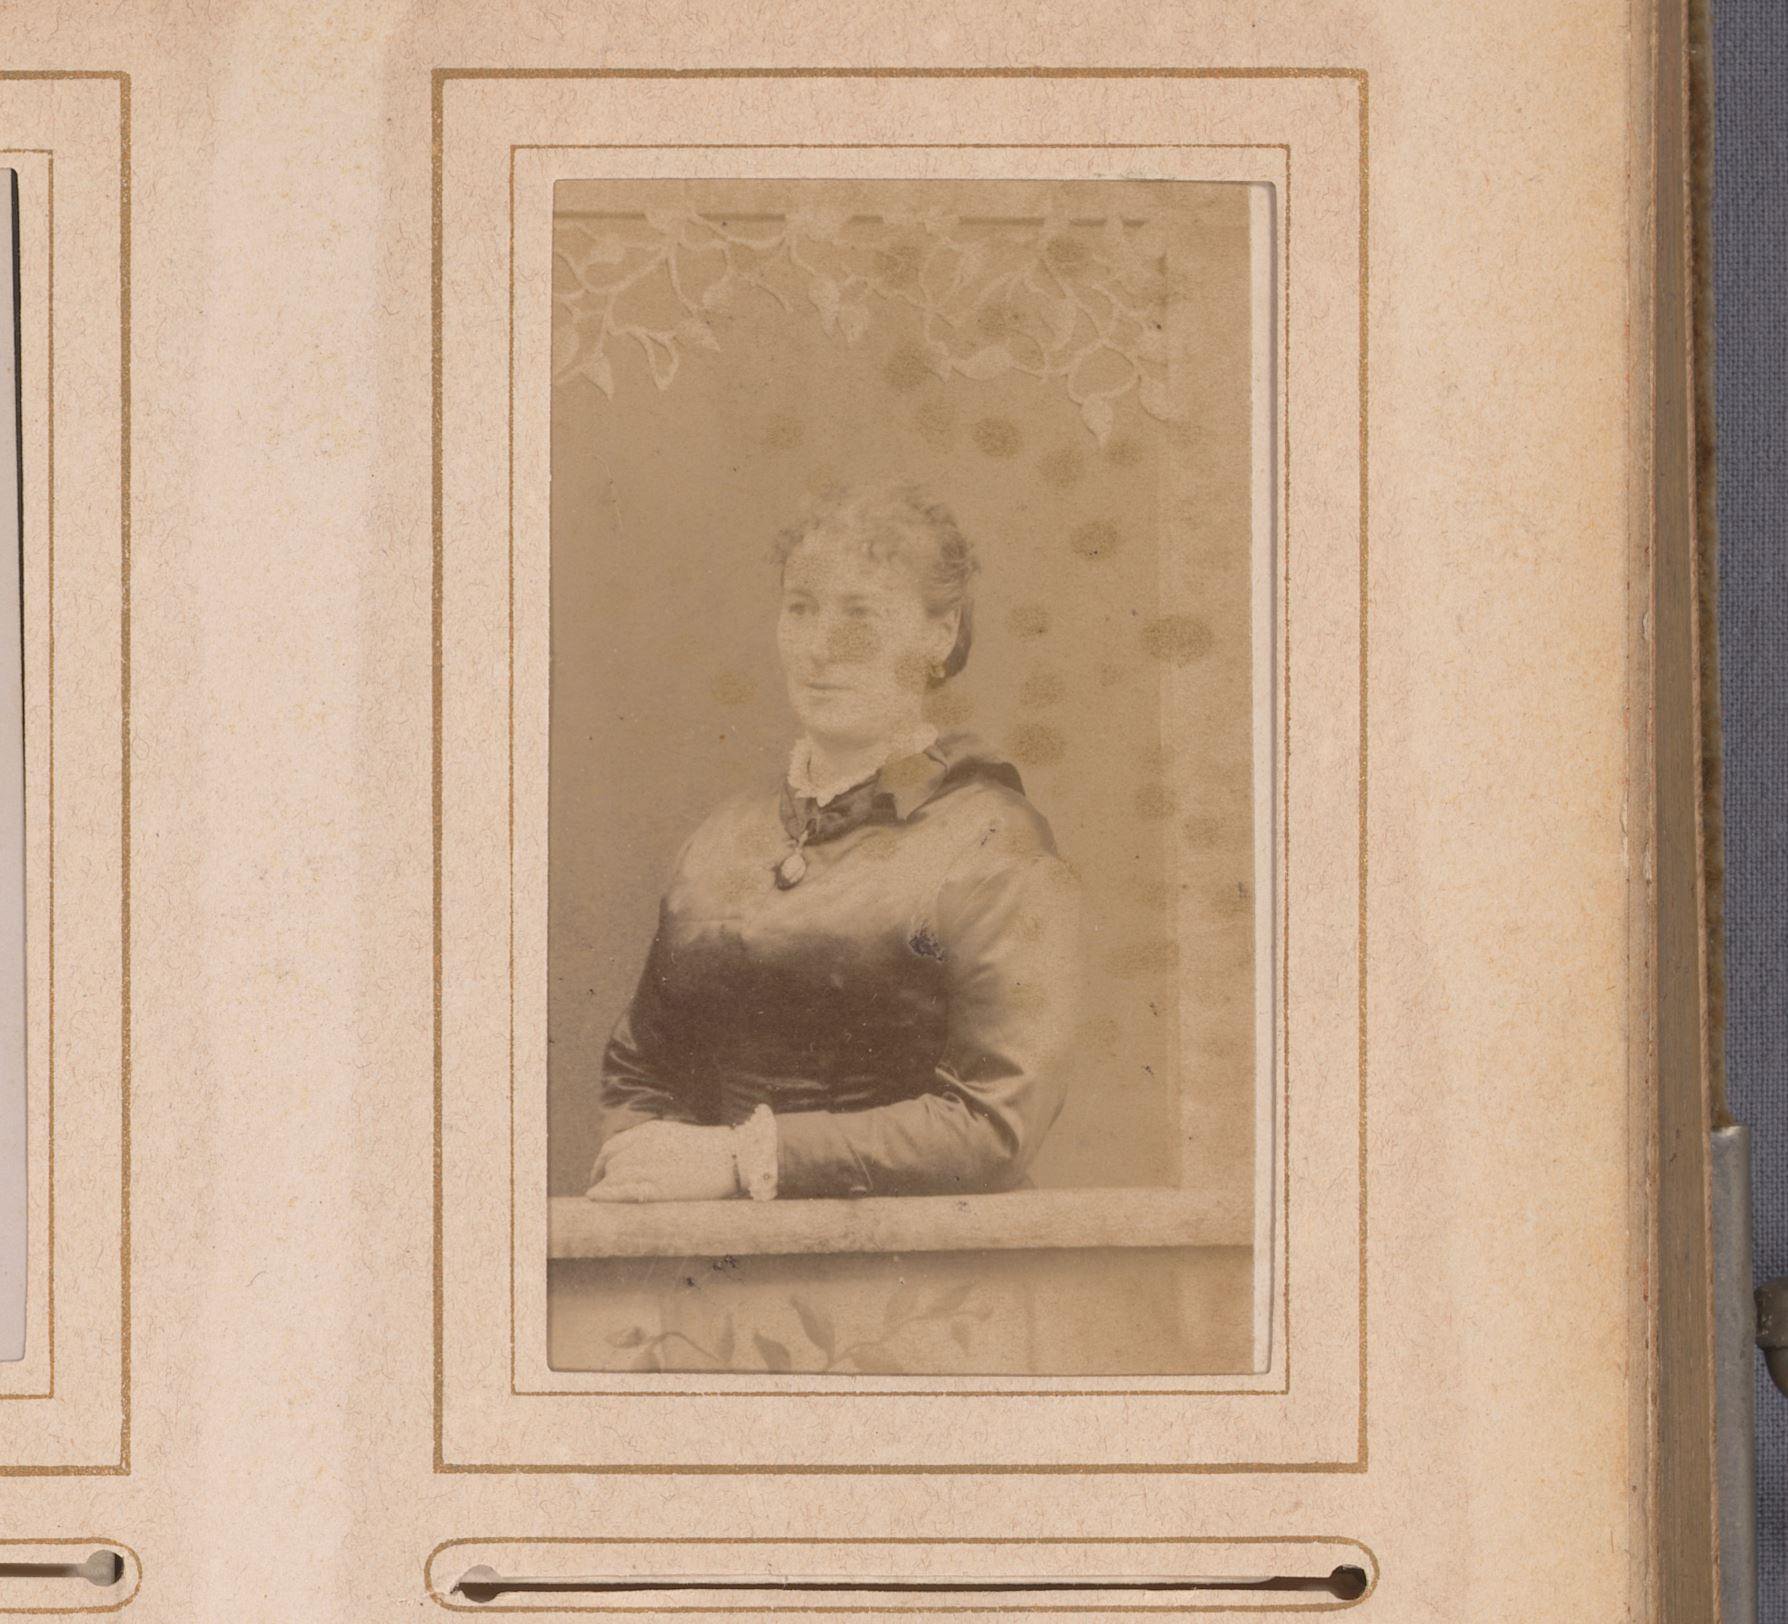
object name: carte de visite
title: Portret van een vrouw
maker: adolphe zimmermans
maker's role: fotograaf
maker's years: 1858-1922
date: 1870-1900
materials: cardboard, photographic support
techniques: albumen print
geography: the hague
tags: historical persons - bb - woman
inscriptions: inscription: ‘Adolphe Zimmermans/ Photographe/ Riemerstraat No 48/ La Haye’